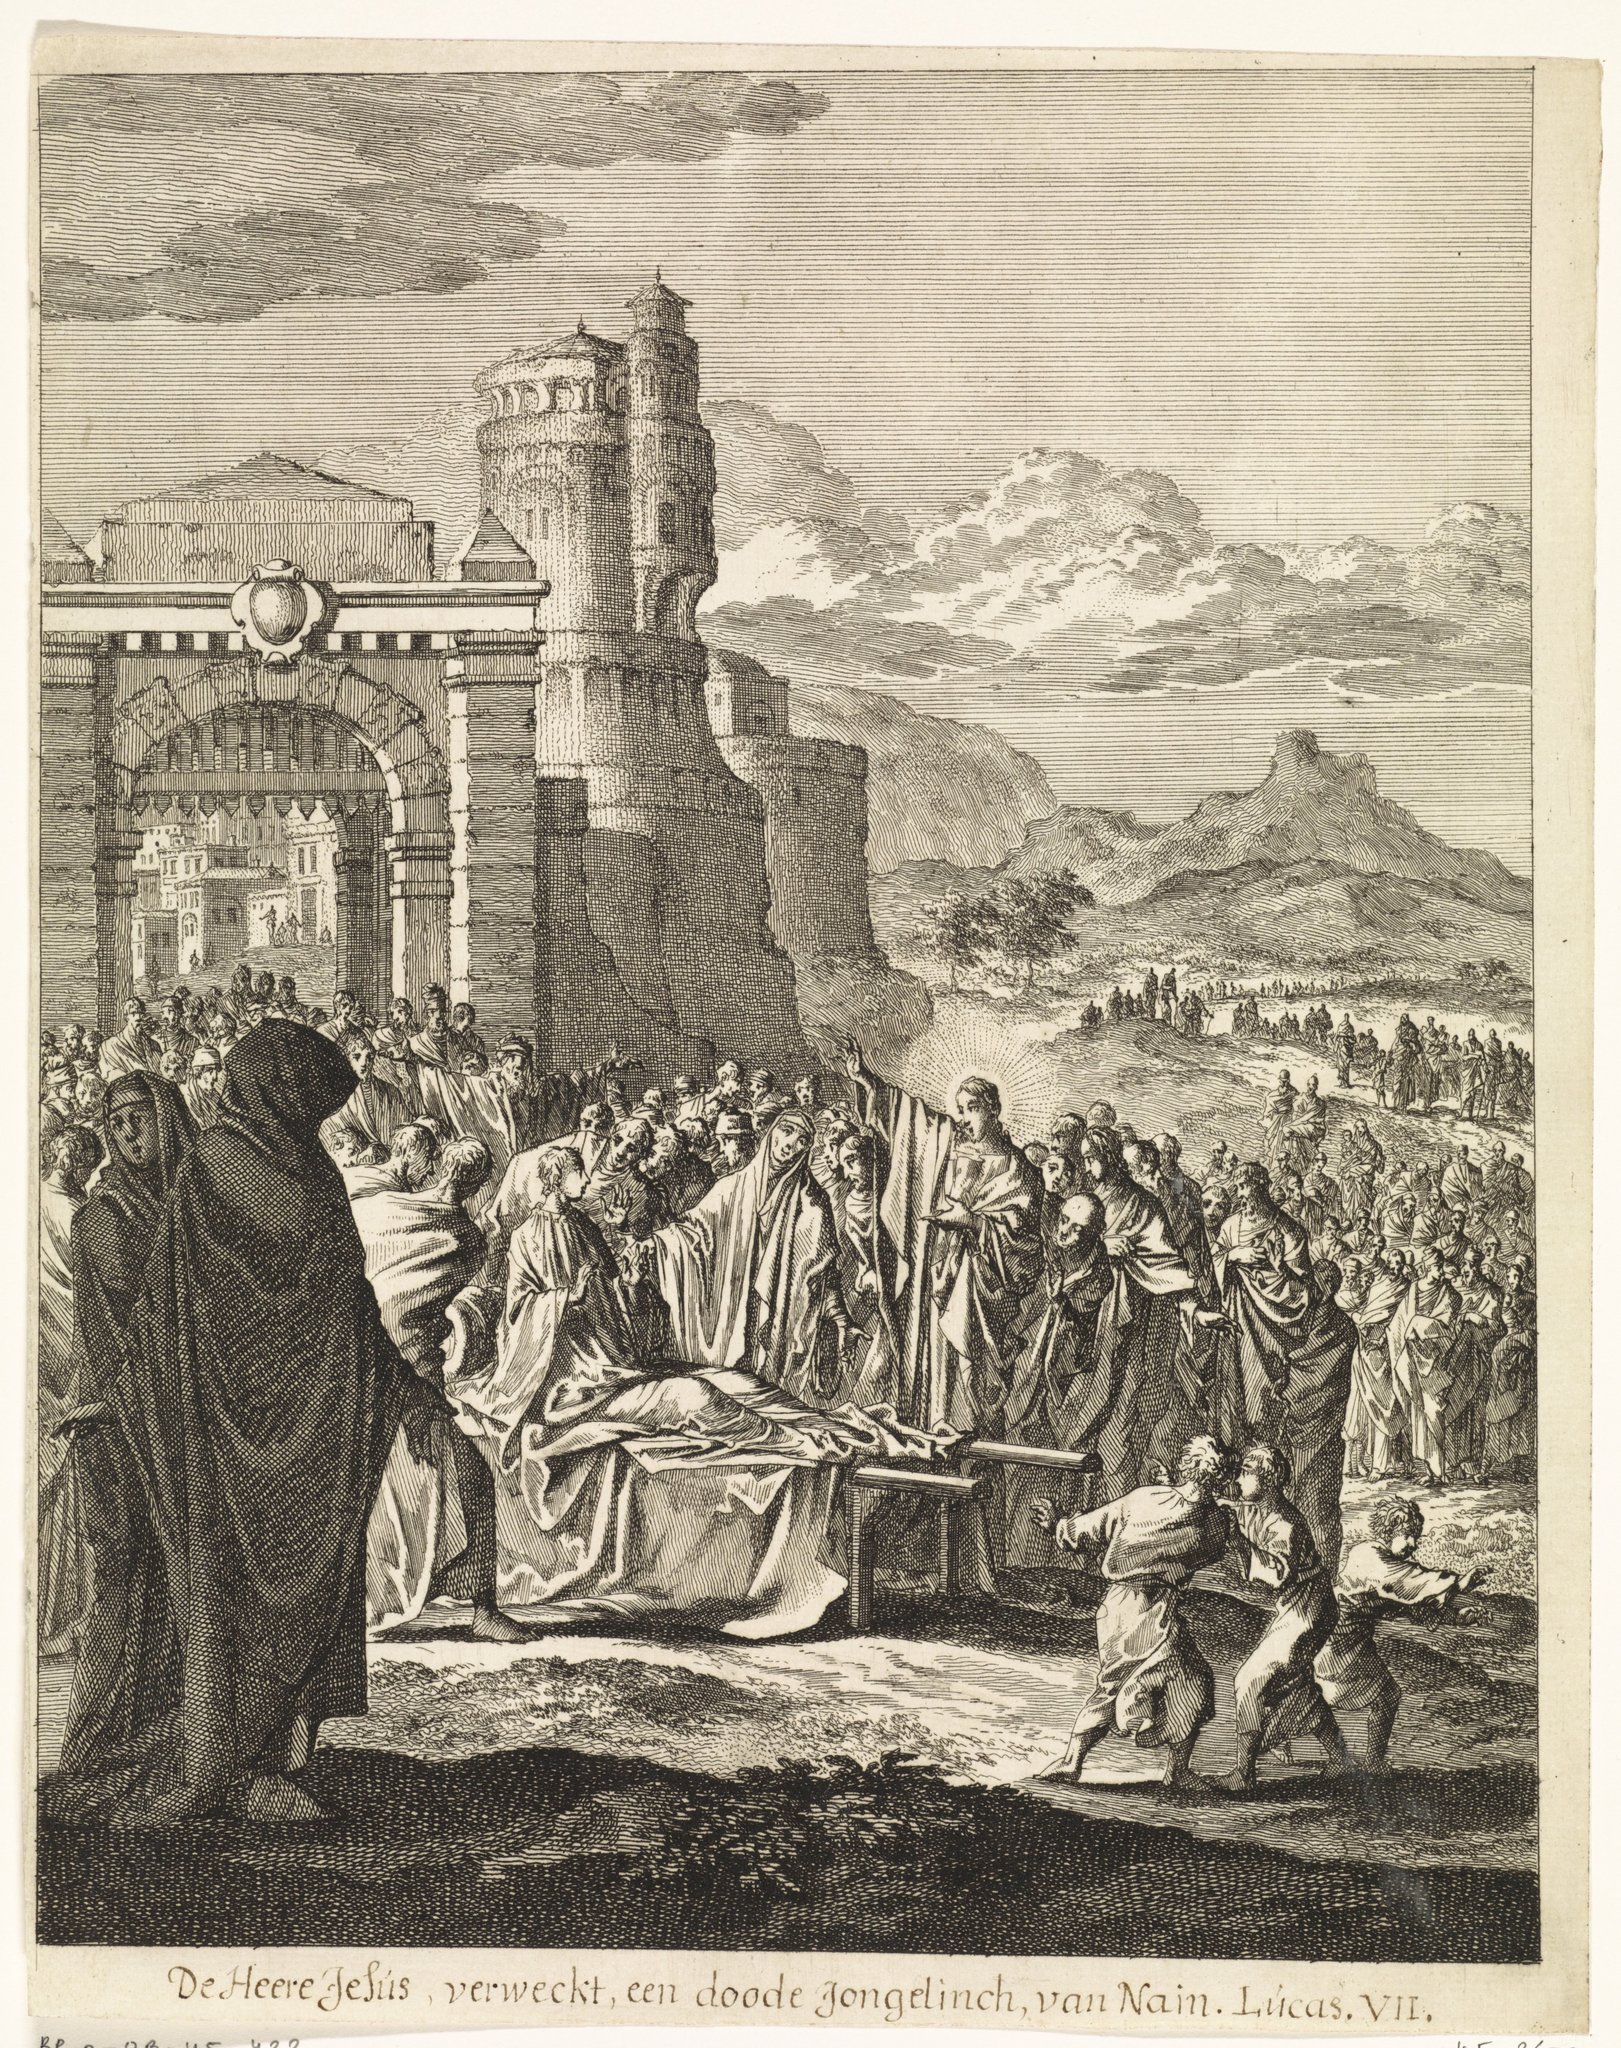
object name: print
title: Opwekking van de zoon van de weduwe te Nain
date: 1708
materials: paper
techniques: etching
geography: amsterdam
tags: christ touches the bier of the son of the widow of nain: the young man sits up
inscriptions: collector's mark: Lugt 2228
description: Proefdruk van een prent welke is opgenomen als illustratie in: Historiae Celebriores Veteris Testamenti. Christoph Weigel, 1708.